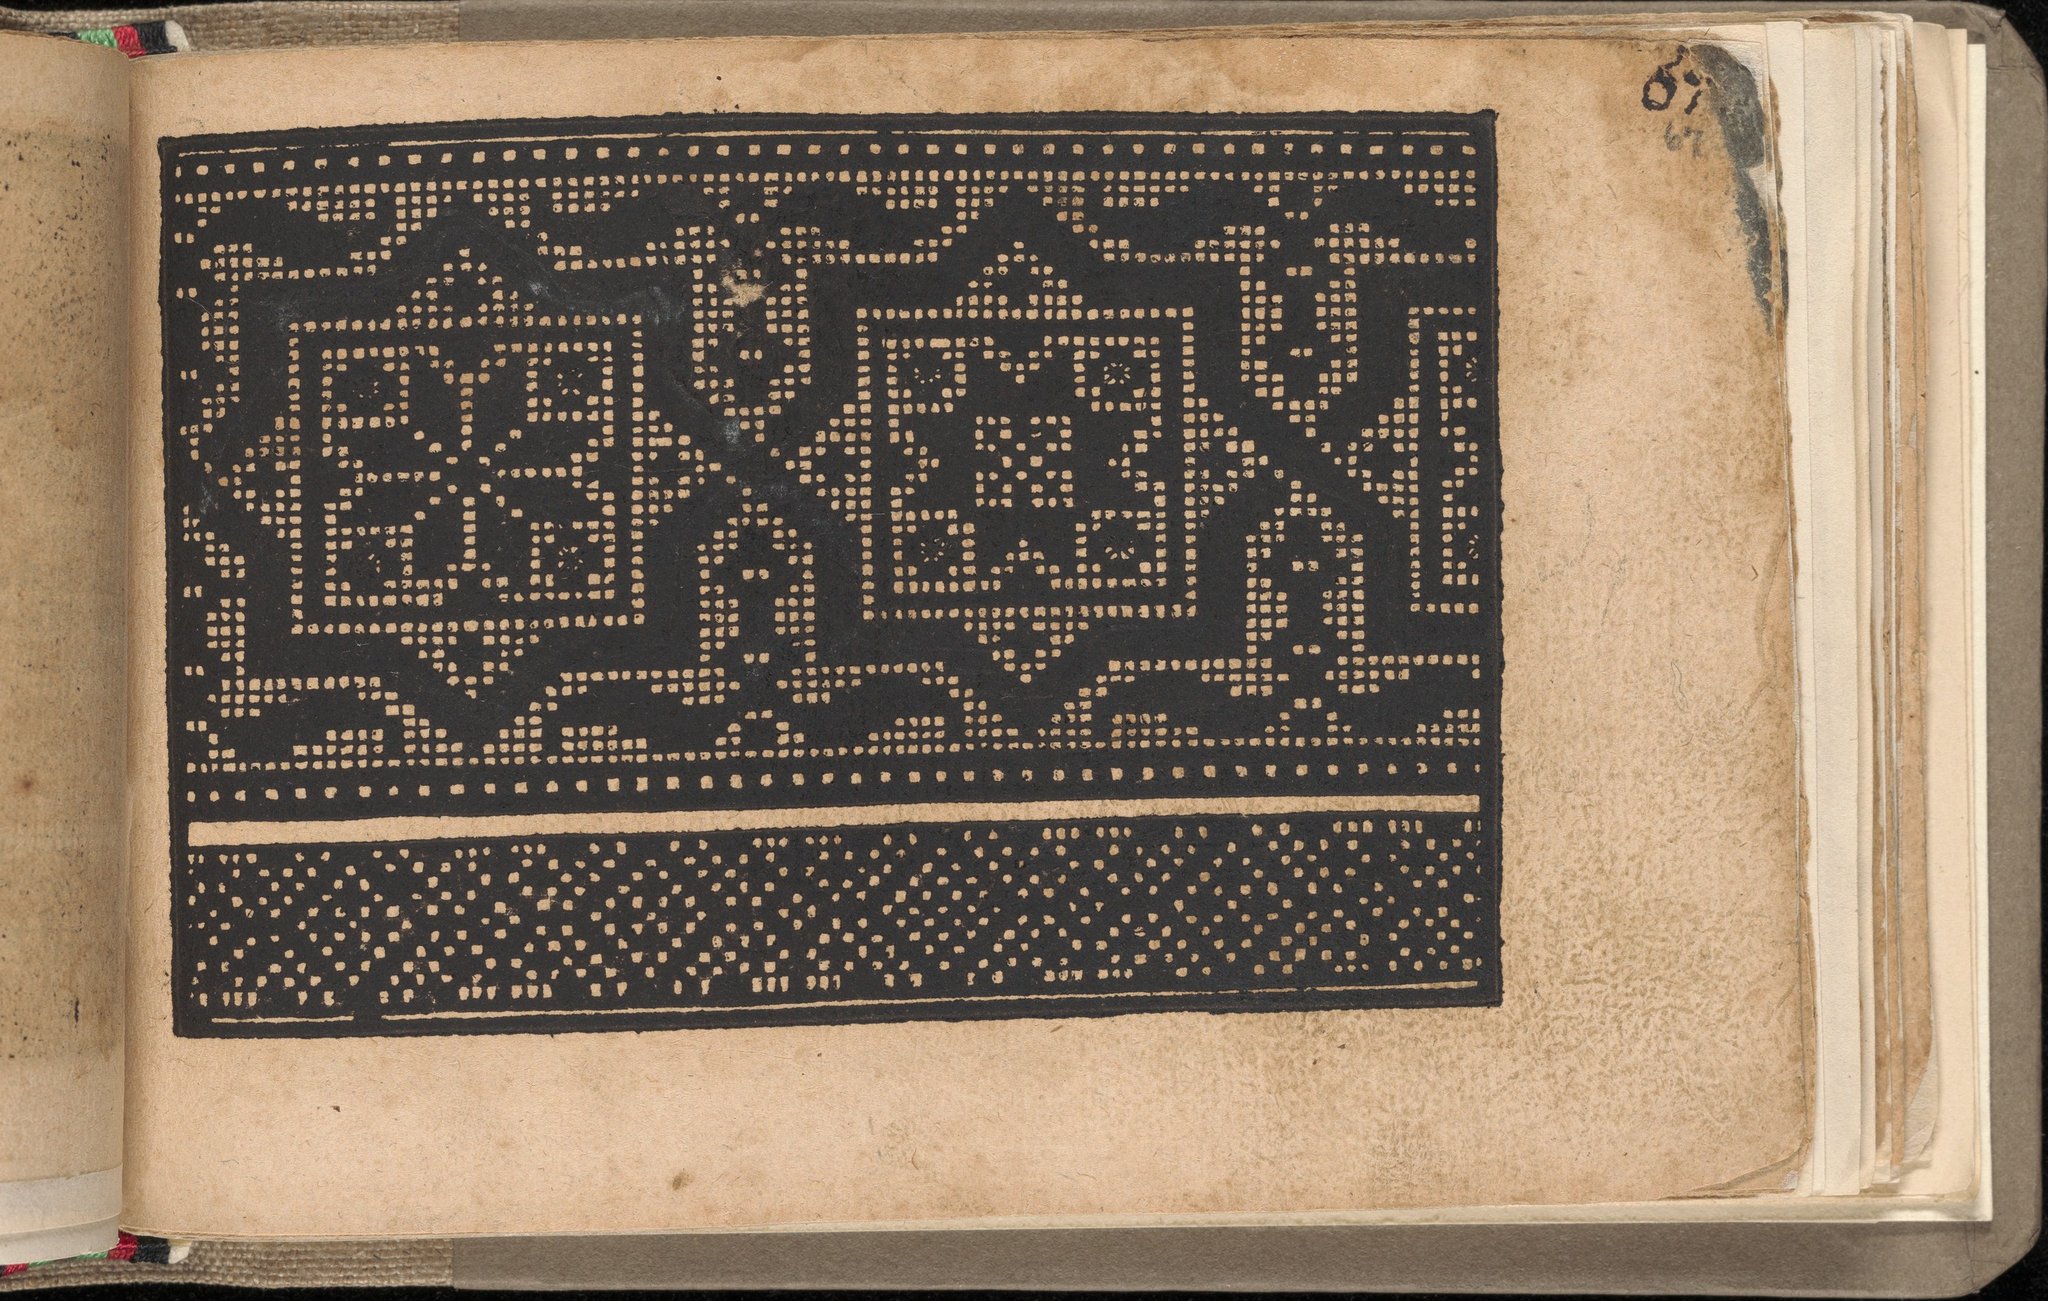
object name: book print ornament architecture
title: Schön newes Modelbuch (Page 67r)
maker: sigismundus latomus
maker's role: publisher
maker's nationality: german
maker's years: 1599-1632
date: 1608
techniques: woodcut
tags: ornament